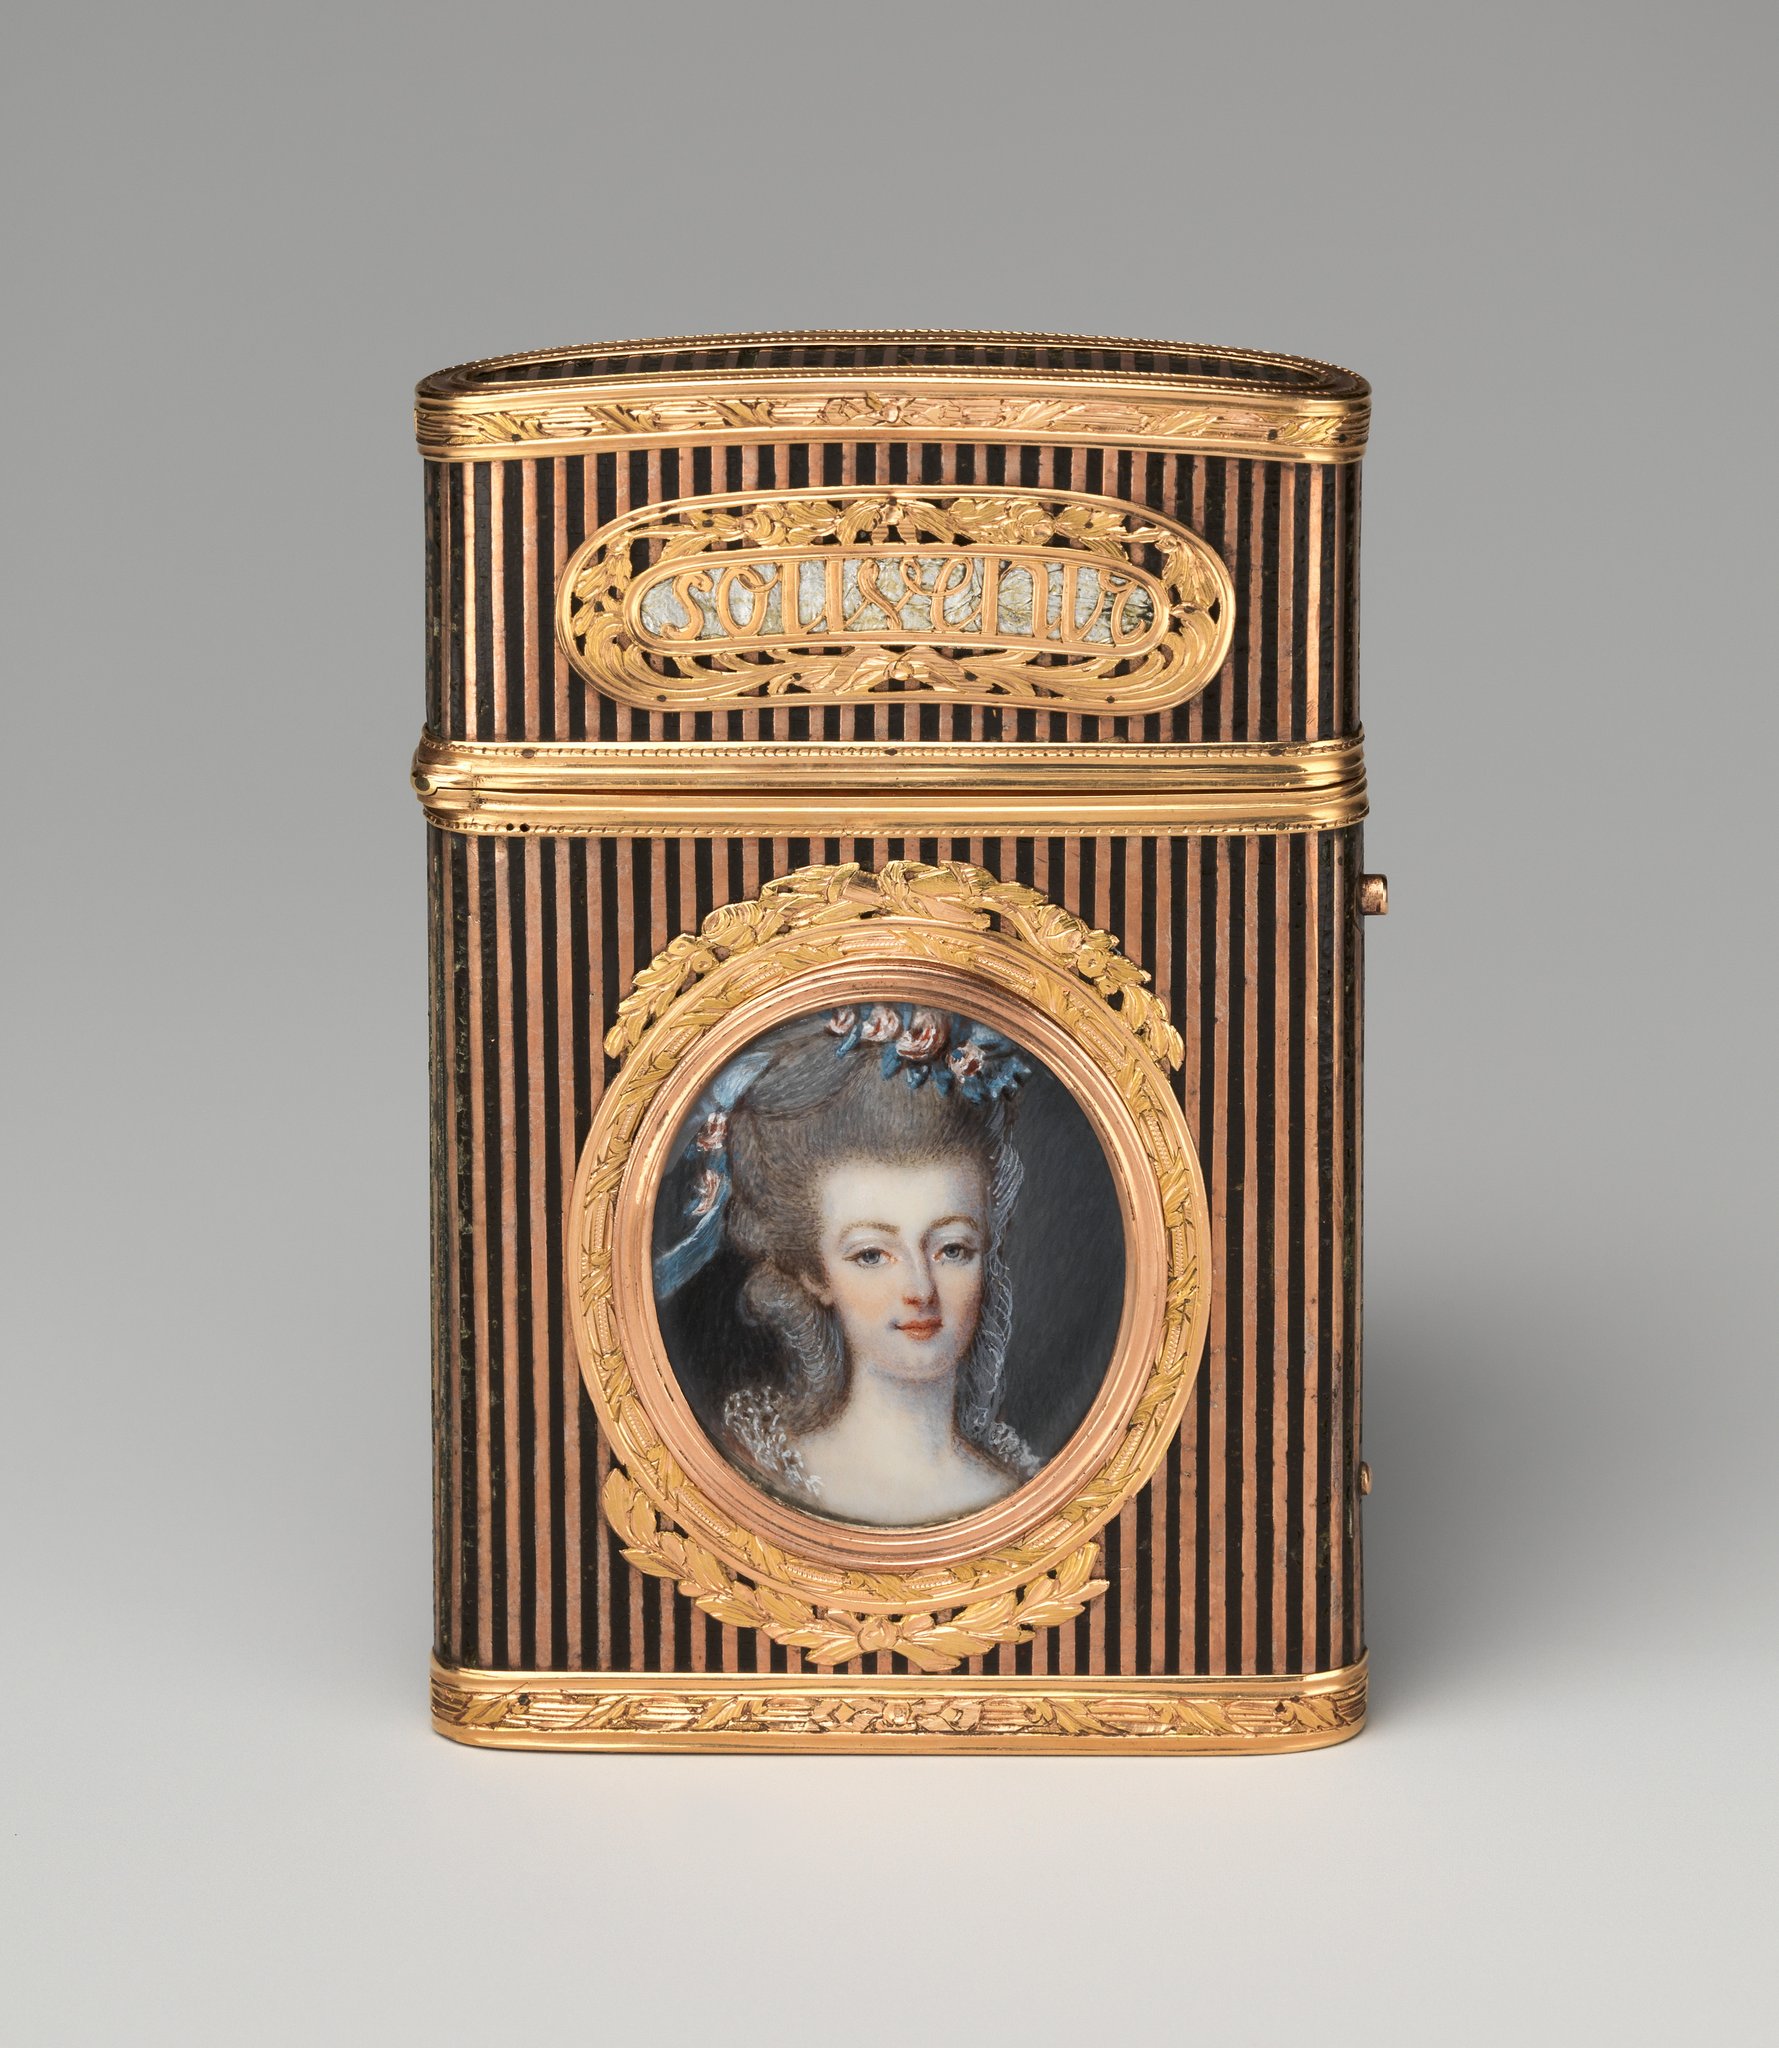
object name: souvenir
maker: louis marie sicardi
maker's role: artist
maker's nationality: french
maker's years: 1743-1825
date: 1770-1771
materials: gold, ivory, shell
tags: portraits,women